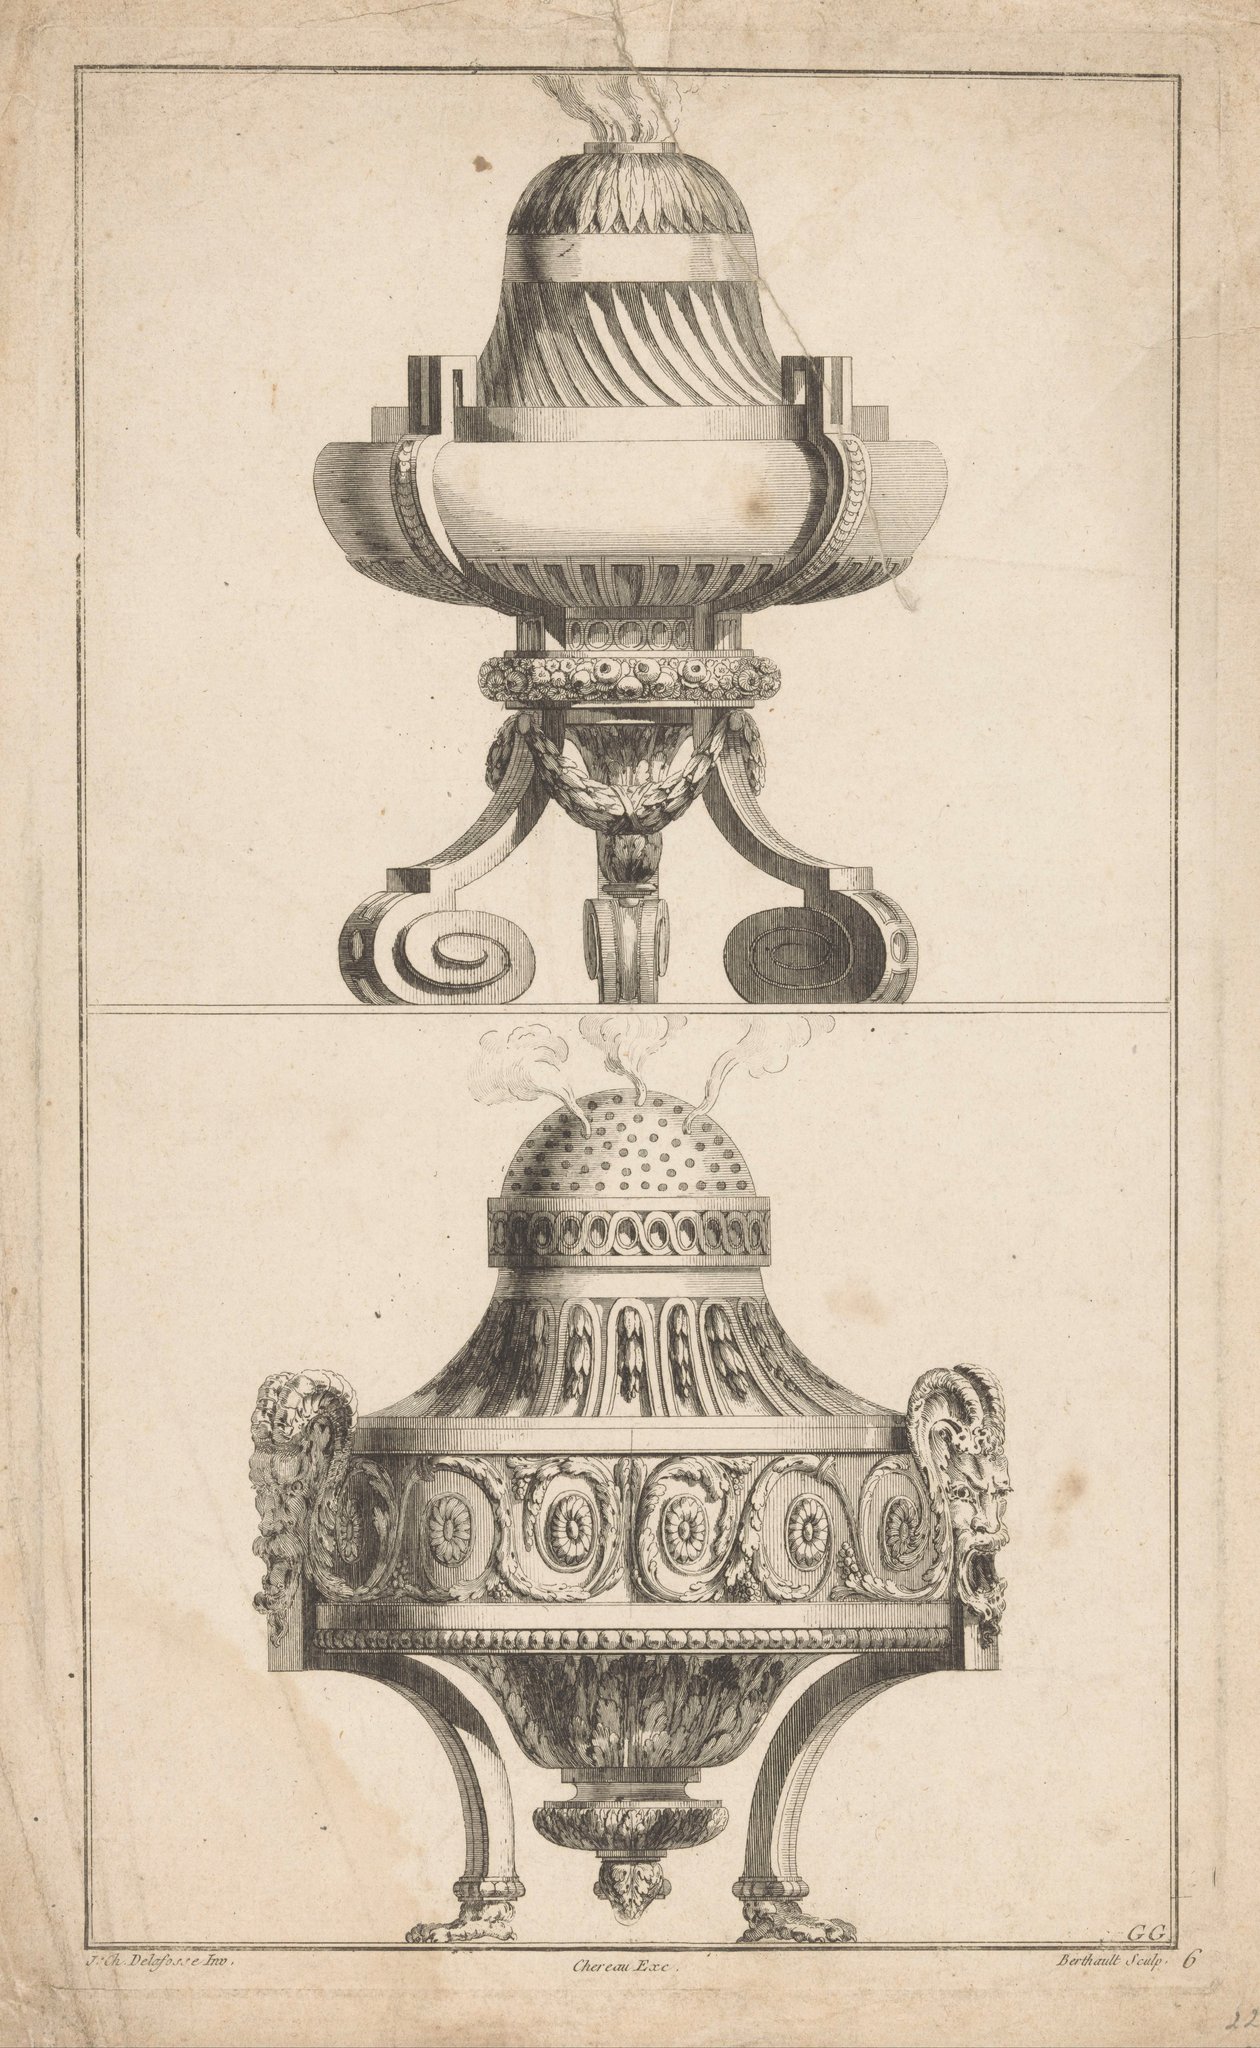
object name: print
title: Twee rookvaten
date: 1771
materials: paper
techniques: engraving, etching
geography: paris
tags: incense-burner ~ scents, perfumes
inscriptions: collector's mark: Lugt 2228, collector's mark: Lugt 2760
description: Twee geornamenteerde rookvaten, onder met mannenkoppen met ramshoorns.